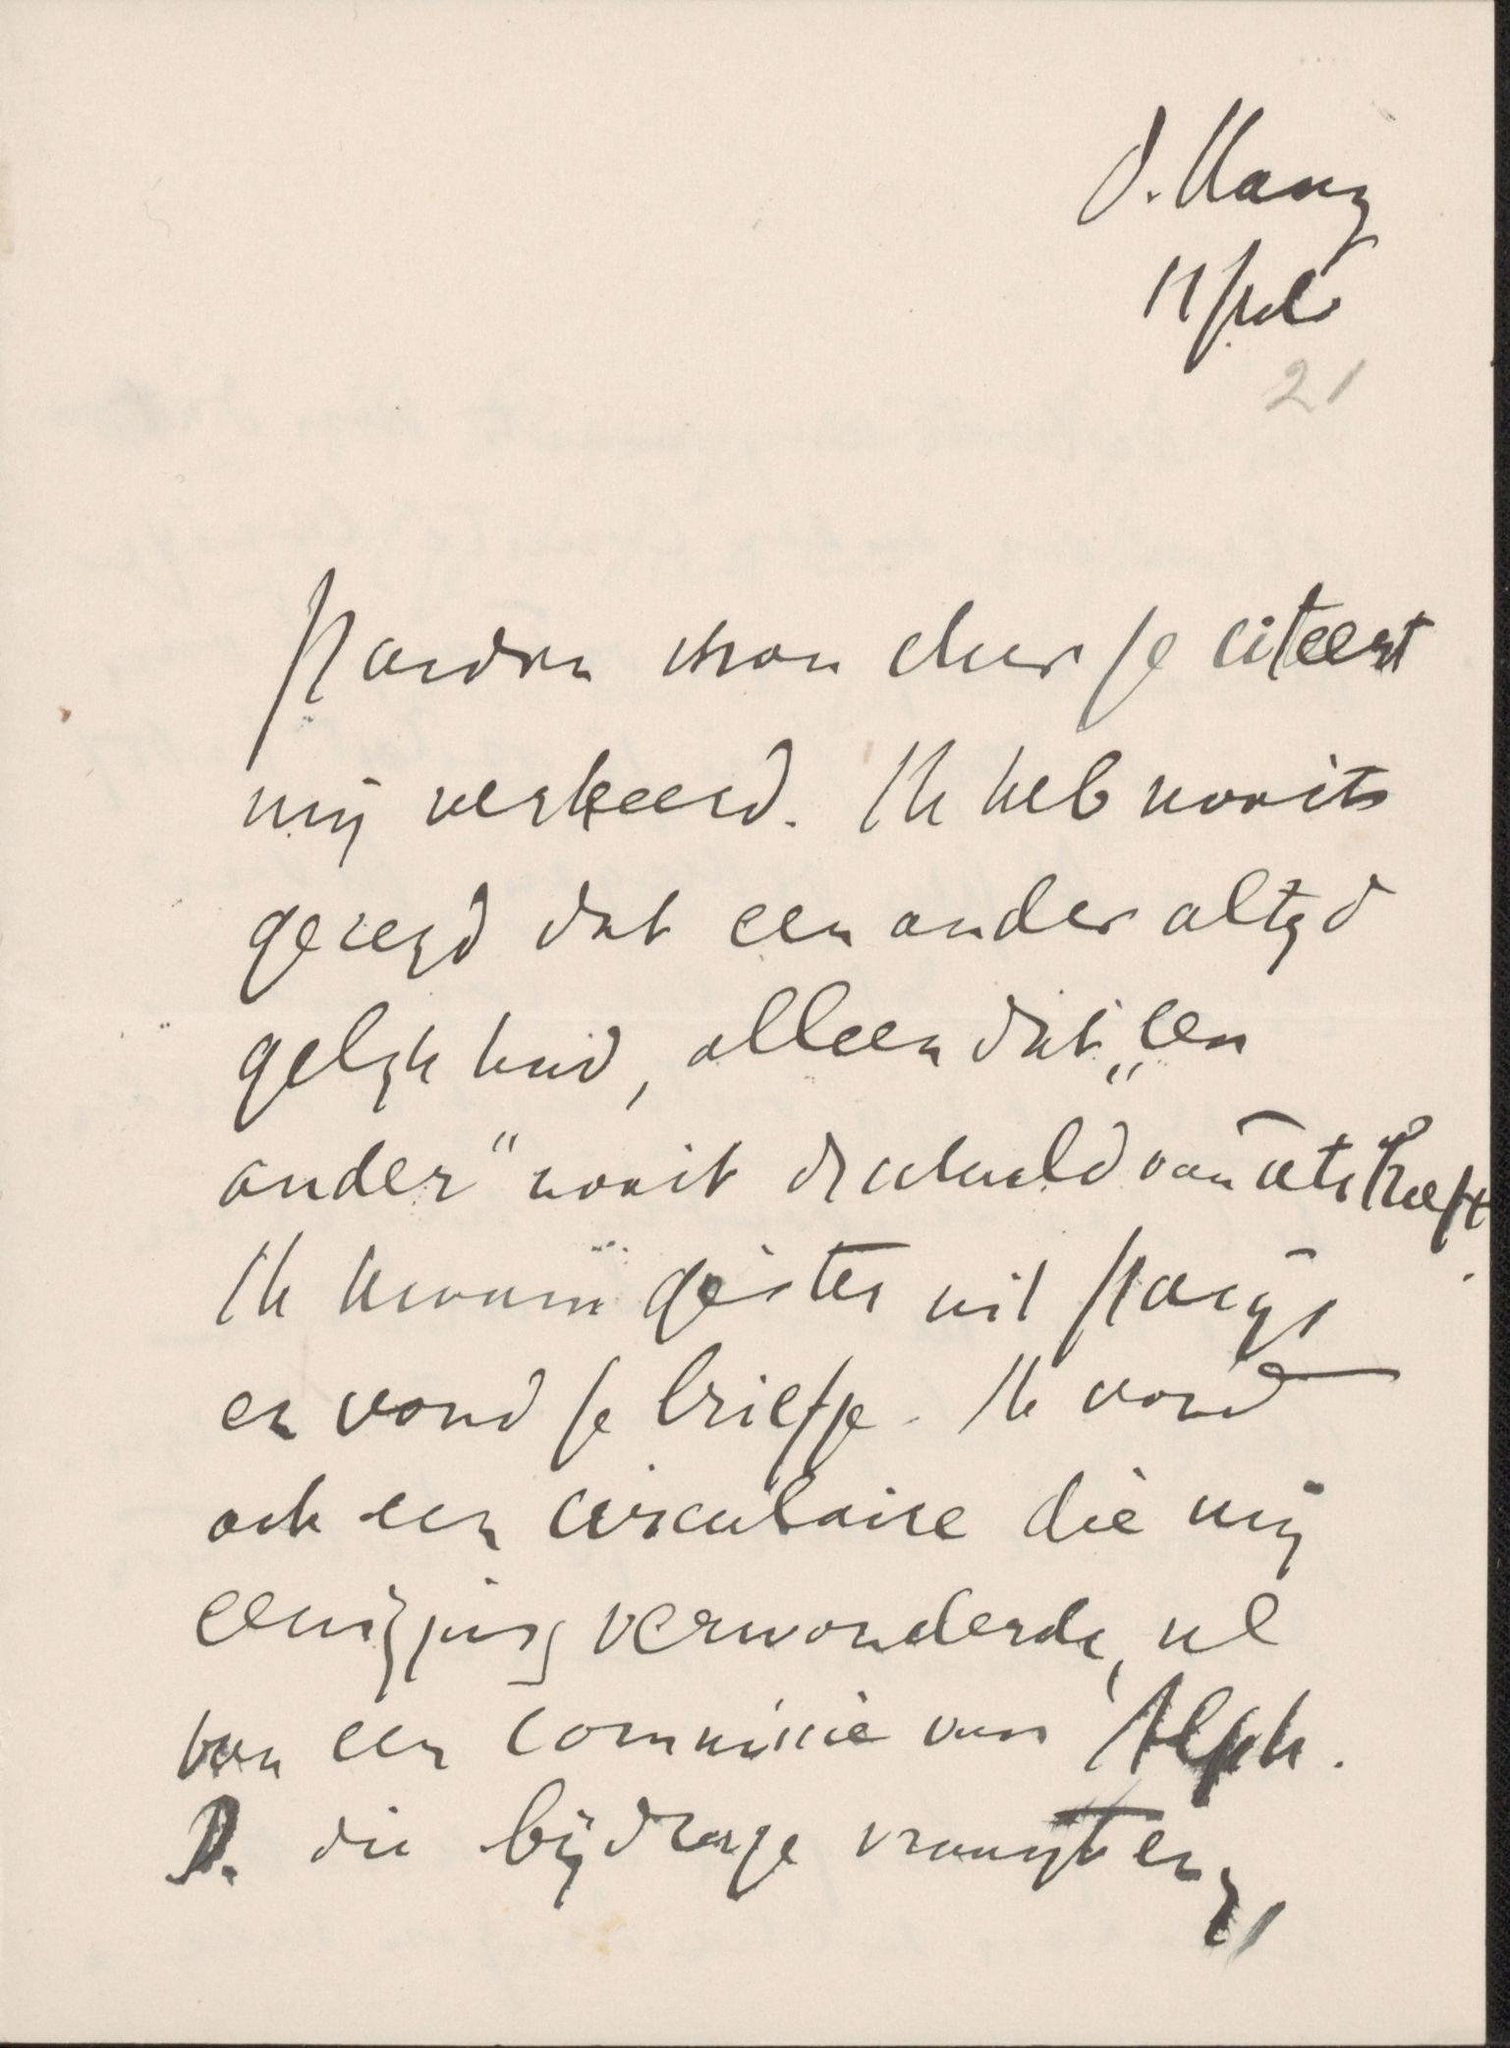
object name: letter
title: Brief aan Jan Veth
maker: isaac israels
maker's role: draughtsman, painter, print maker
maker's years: 1865-1934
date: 1875-1925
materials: ink, paper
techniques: pen, writing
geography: the hague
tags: dordrecht, painter, print maker, draughtsman, designer, jan veth, willem witsen, suze robertson, paris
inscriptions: collector's mark: ‘RPK’